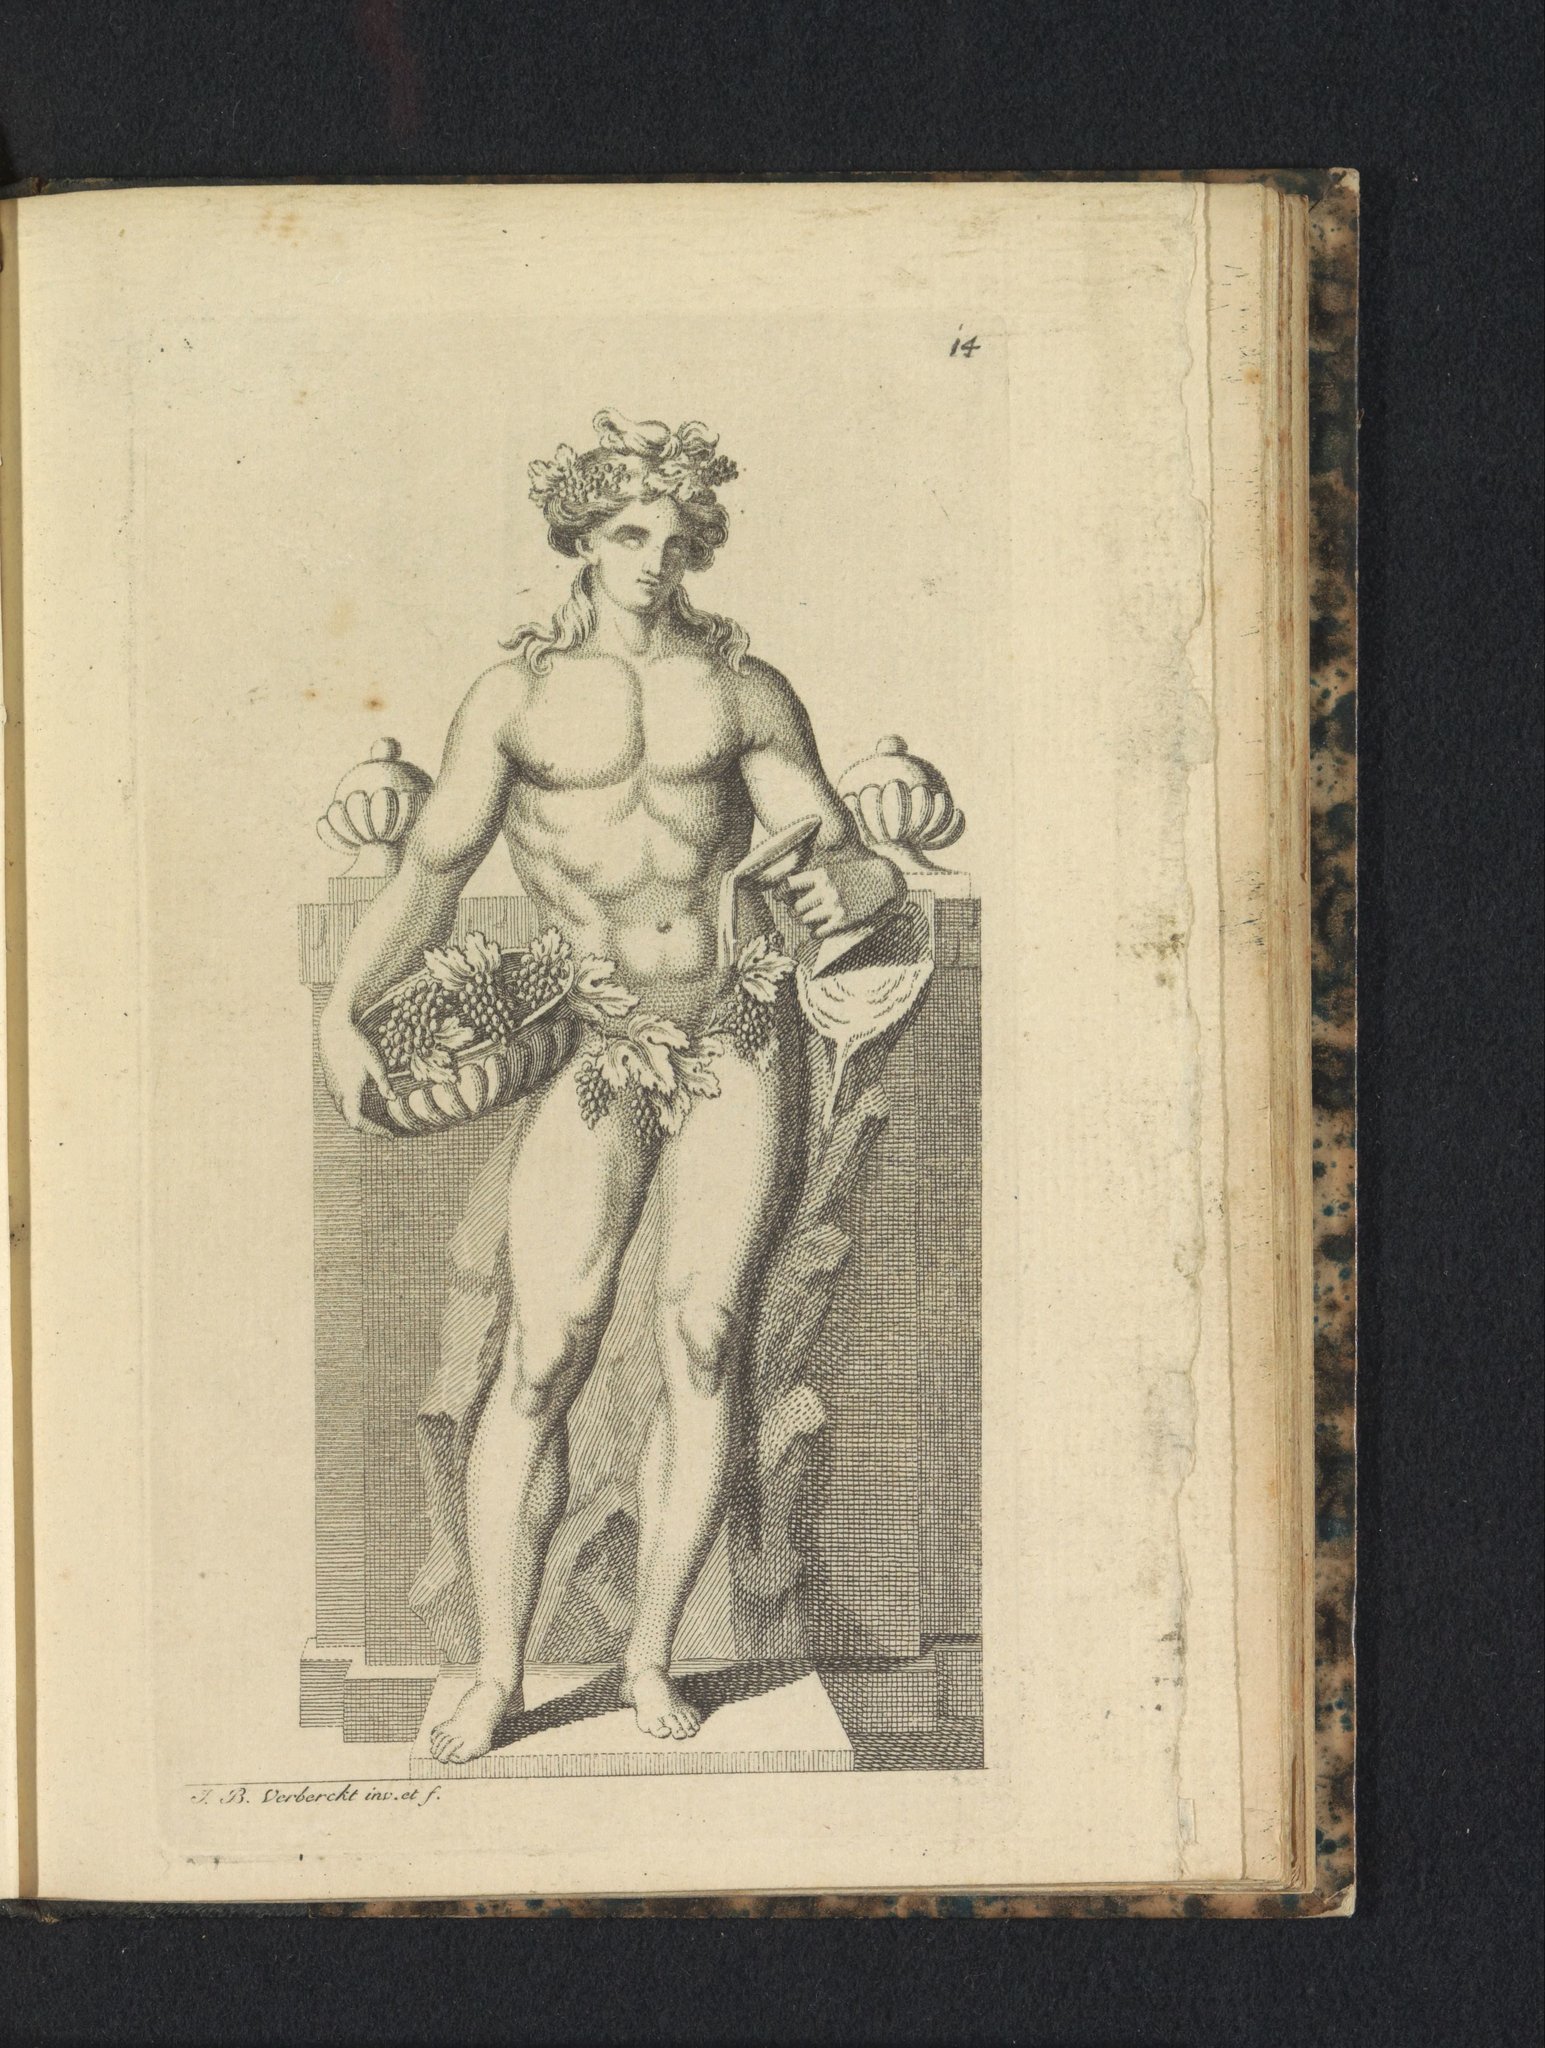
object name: print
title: Bacchus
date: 1772-1773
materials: paper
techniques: engraving, etching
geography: southern netherlands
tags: (story of) bacchus (dionysus), liber, piece of sculpture, reproduction of a piece of sculpture (+ clay, sand, etc. ~ arts), antwerp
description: Sculptuur van een staande jonge naakte Bacchus. Beeld gemaakt door J.B. Verberckt. Genummerd rechtsboven in de plaat: 14. Onderdeel van de verzameling van figuren en beelden gemaakt van sneeuw in de straten van Antwerpen in januari 1772.